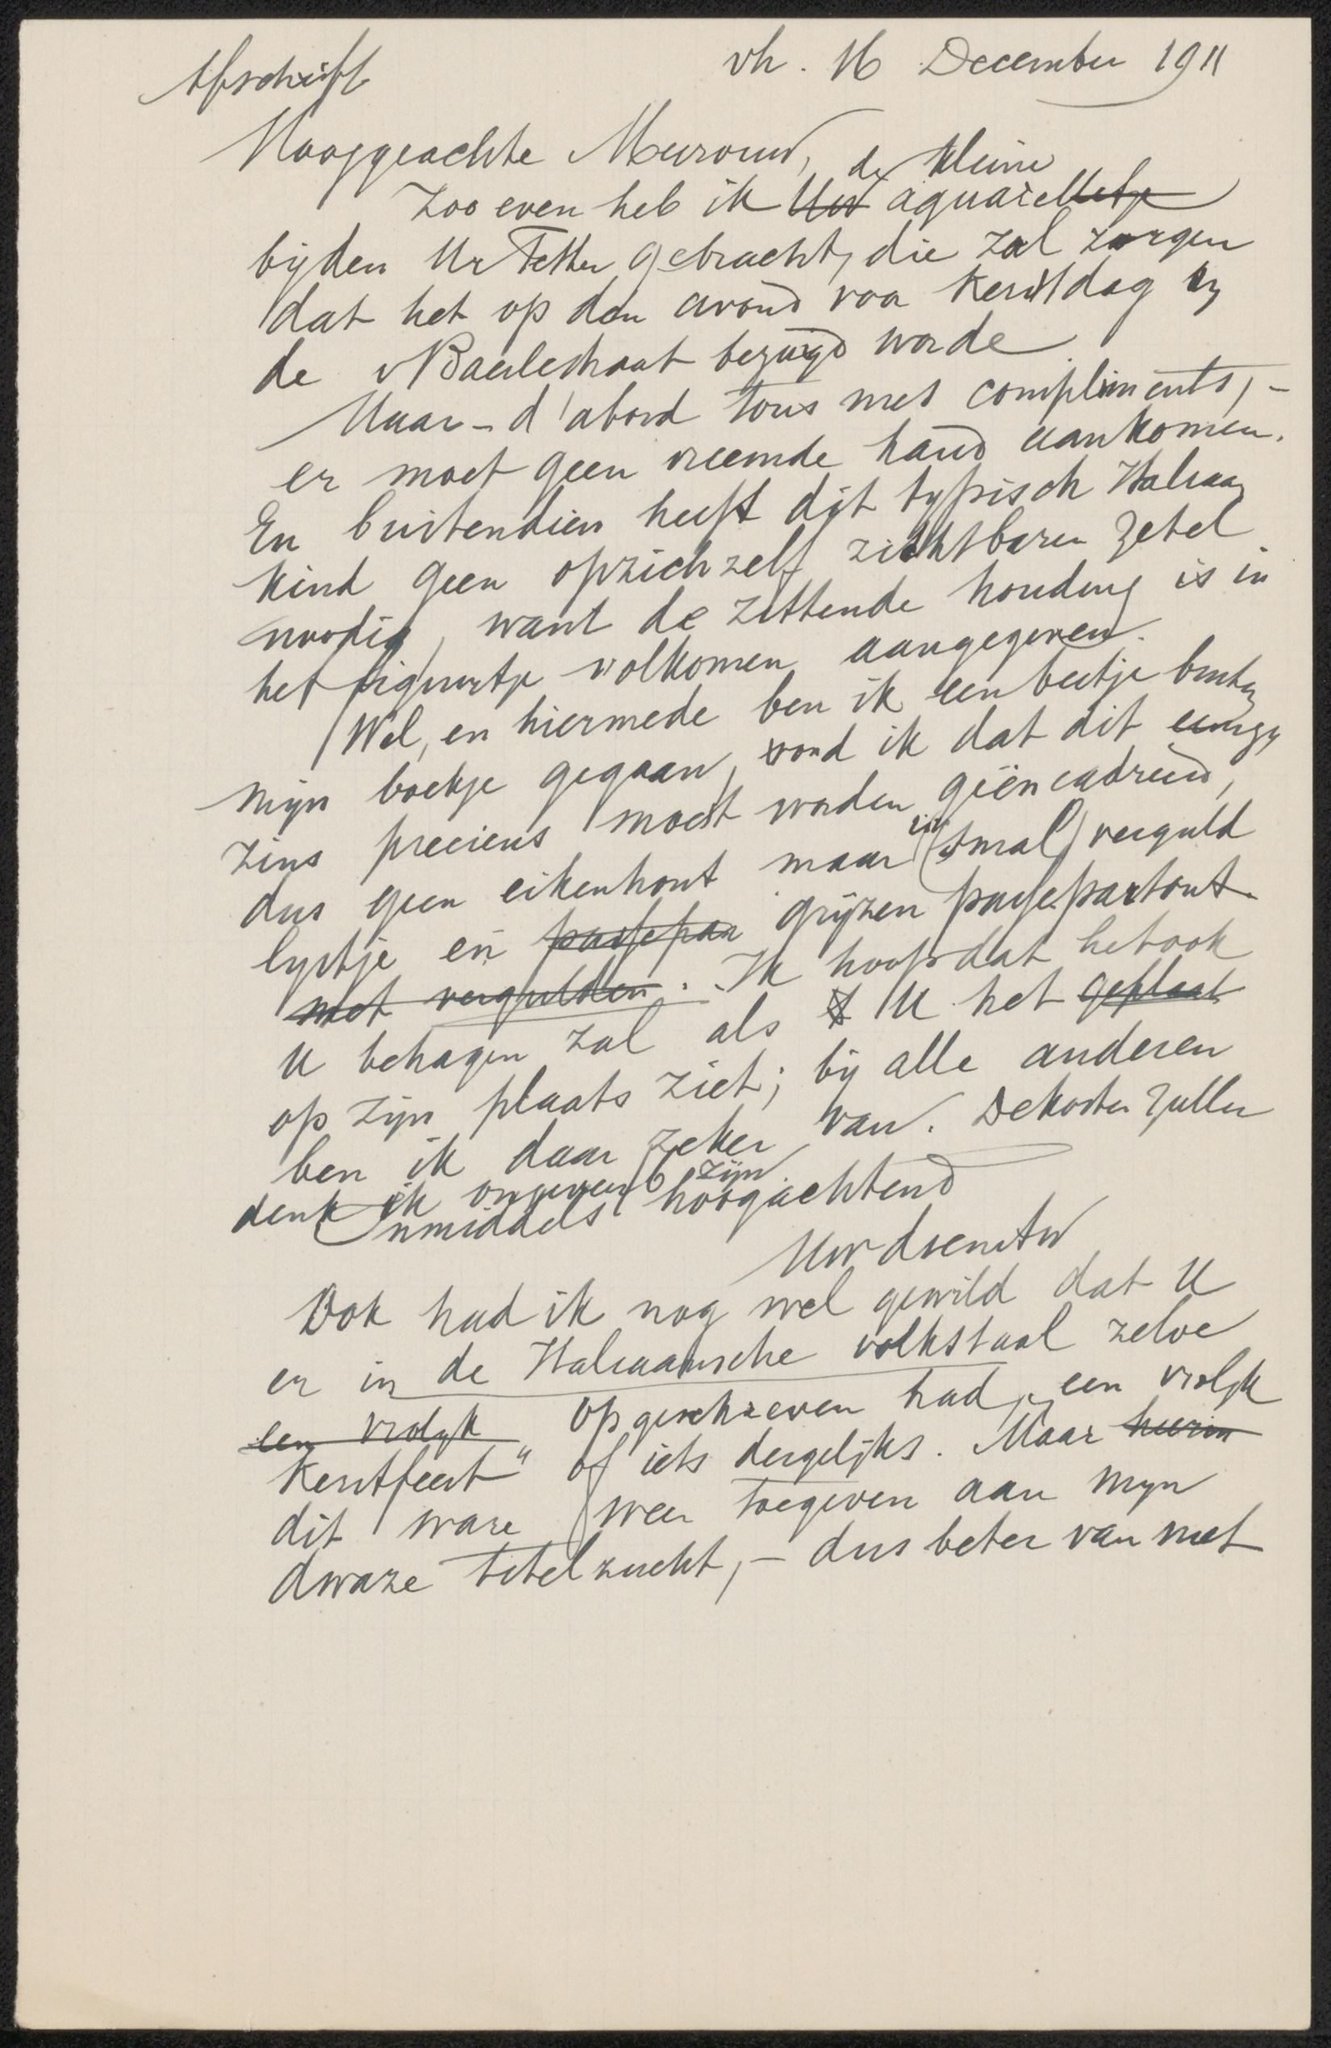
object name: letter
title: Brief aan anoniem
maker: august allebé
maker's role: draughtsman, print maker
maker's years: 1838-1927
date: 1911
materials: ink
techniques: pen, writing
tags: drawing